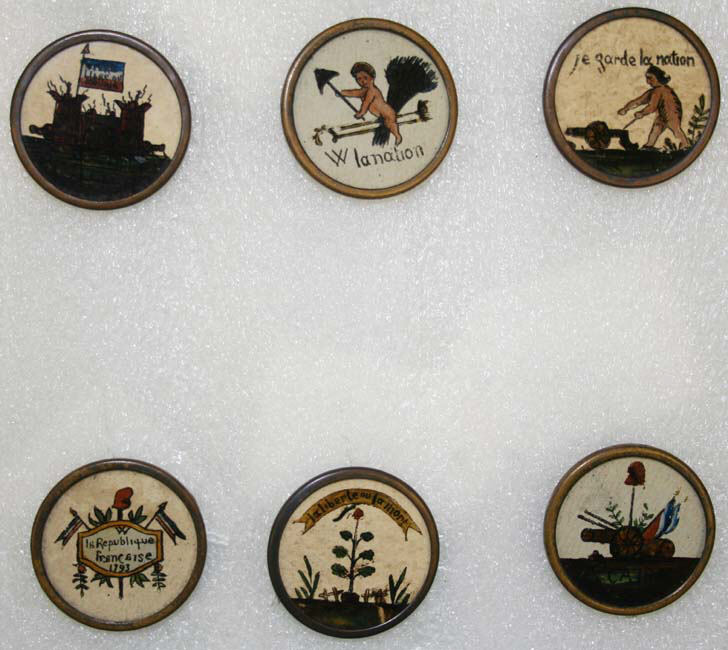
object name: button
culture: french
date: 1801-1900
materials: porcelain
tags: cannons,putti